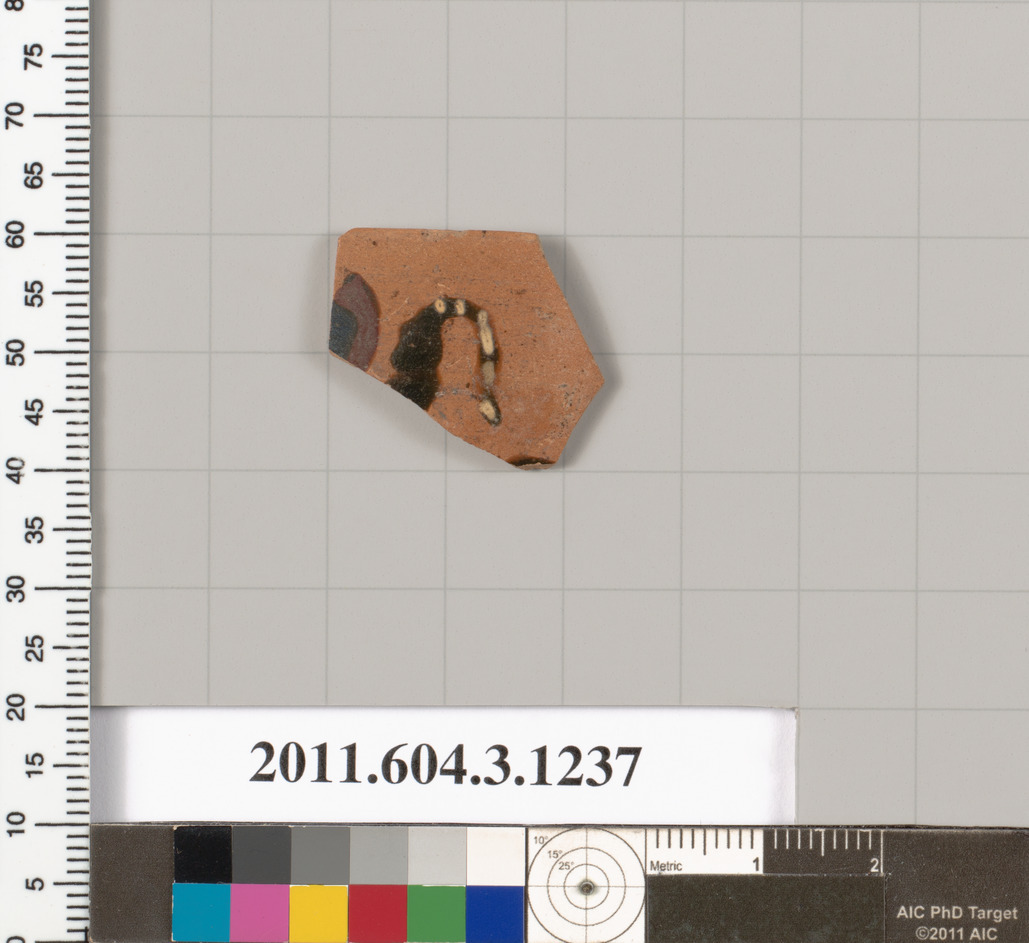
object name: kyathos fragment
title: Terracotta rim fragment of a kyathos (cup-shaped ladle)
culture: greek, attic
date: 534-468 BCE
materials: terracotta